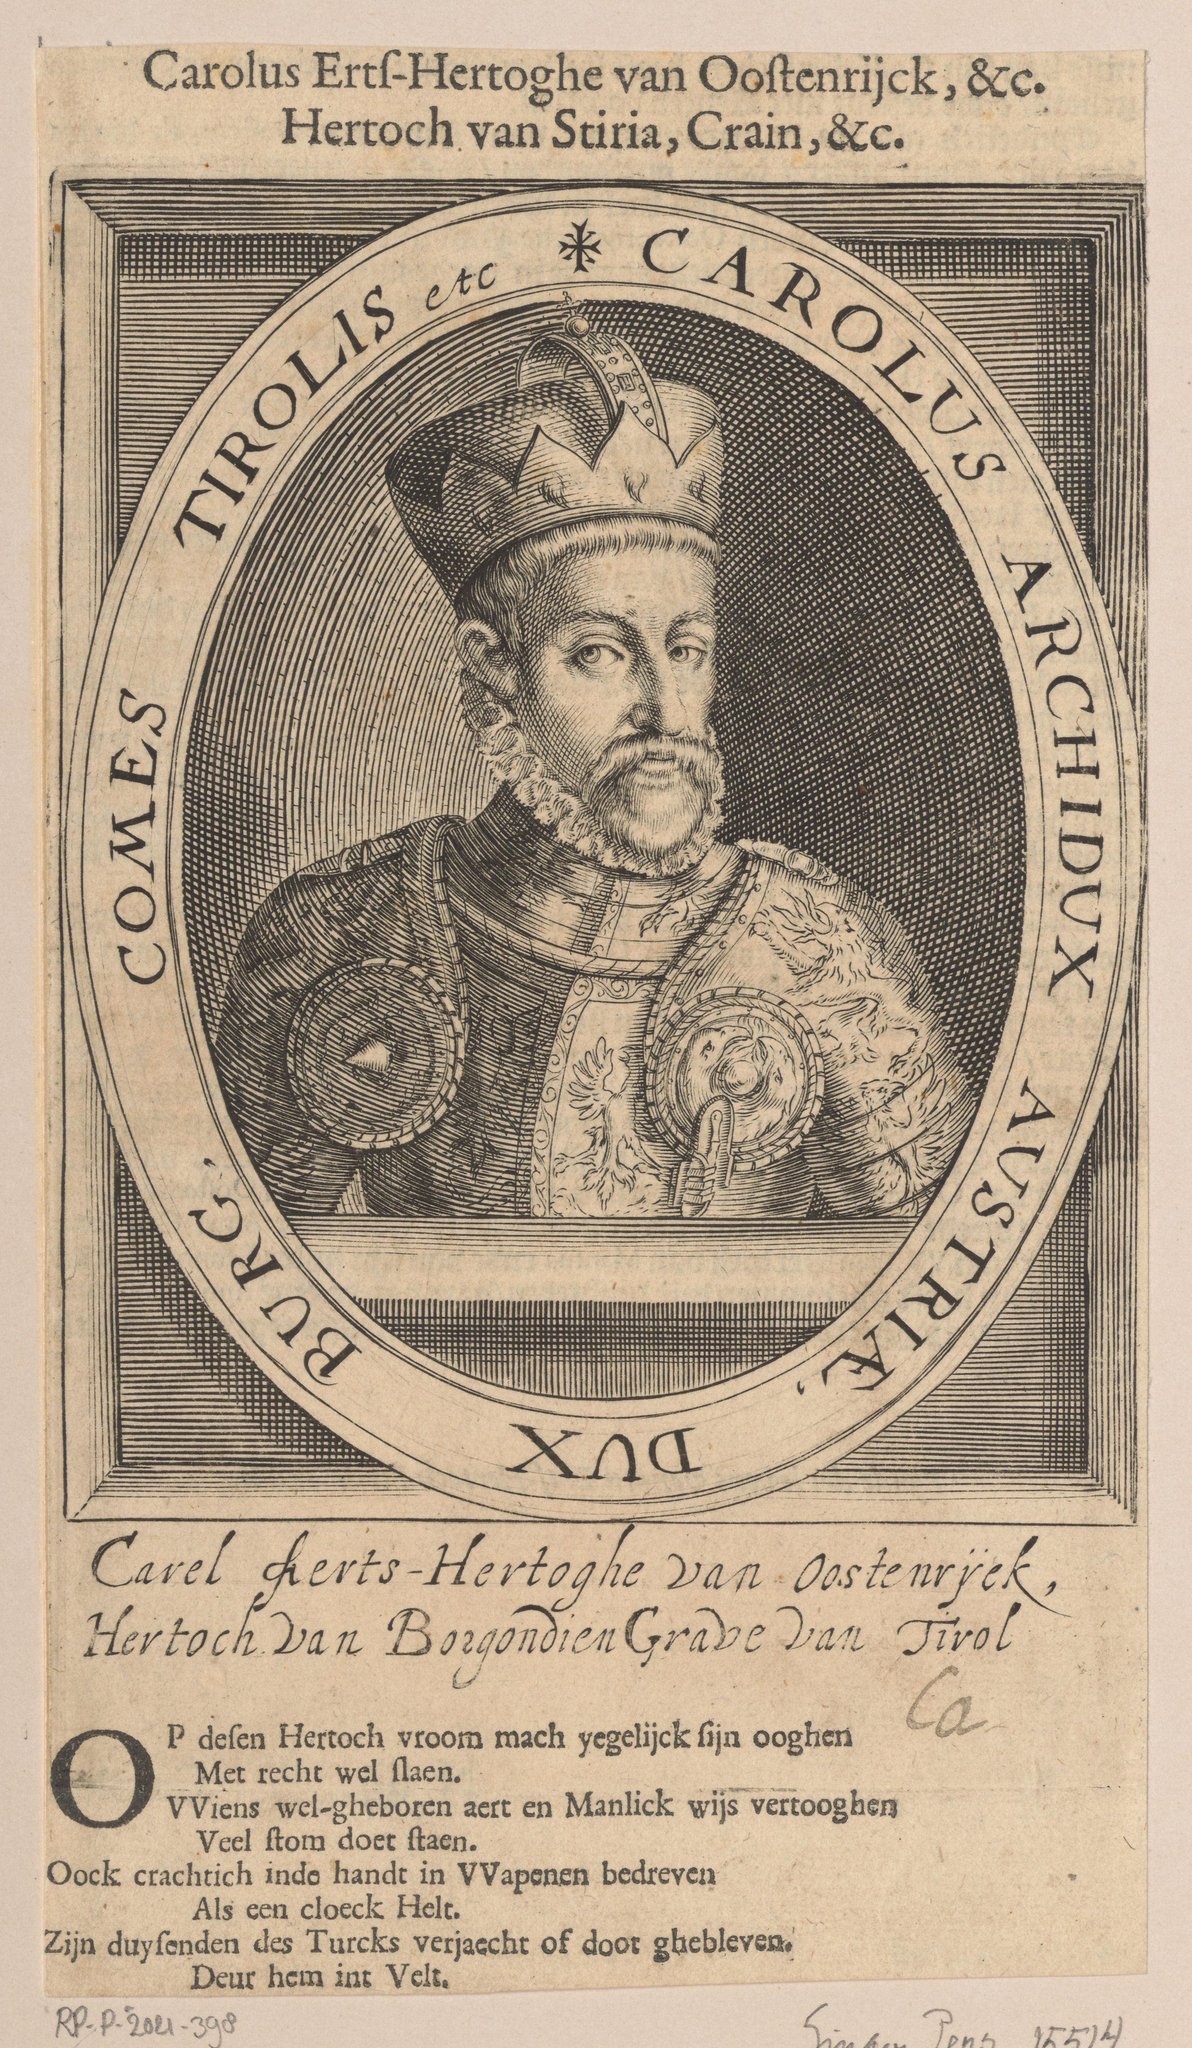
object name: book illustration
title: Portret van Karel II, aartshertog van Binnen-Oostenrijk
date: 1617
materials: paper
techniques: engraving, letterpress printing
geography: delft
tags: karel ii (aartshertog van binnen-oostenrijk), other sovereign, historical persons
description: Prent uit: Clerck, Nicolaes de. Tooneel der beroemder hertogen princen graven (...). Delft: Nicolaes de Clerck, 1617.